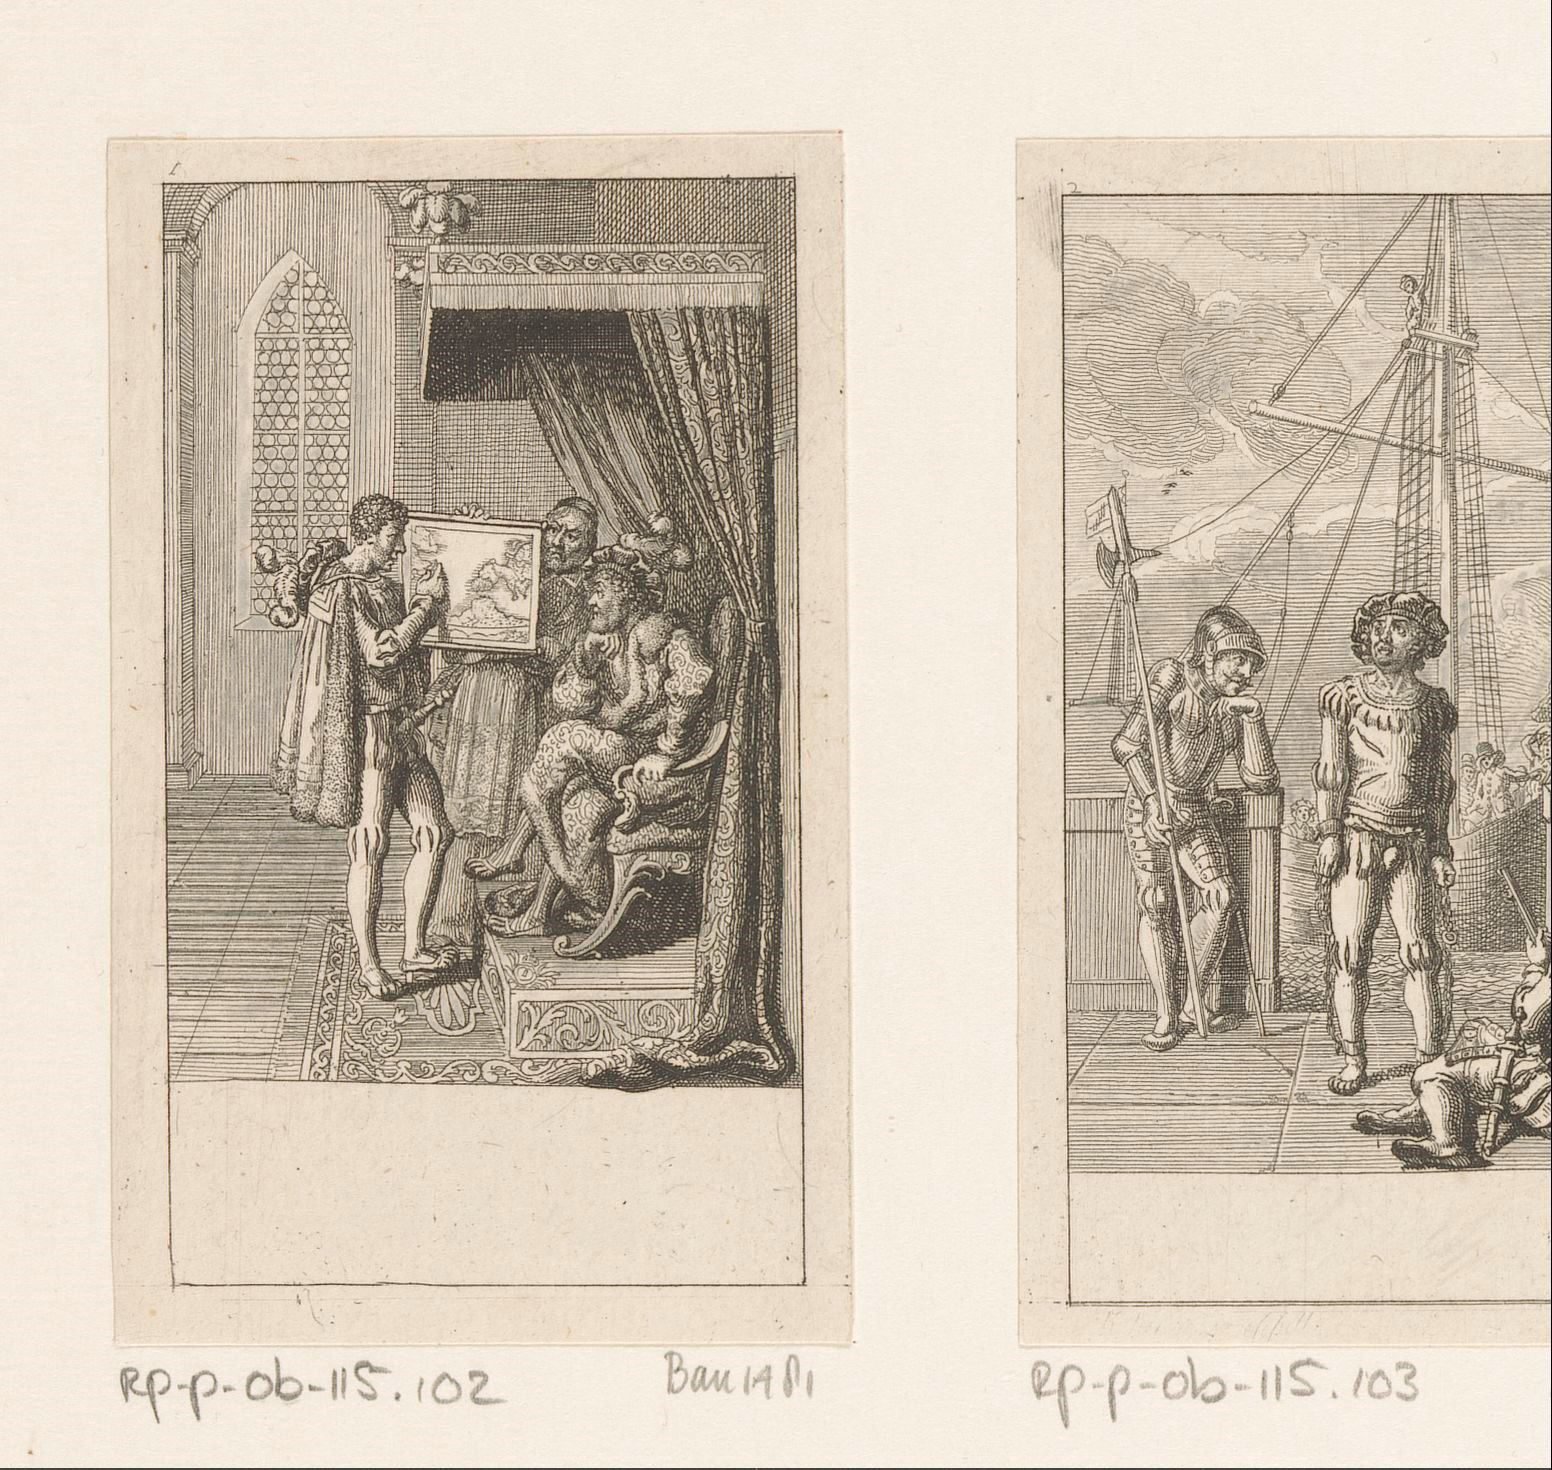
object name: print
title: Columbus legt zijn plan voor aan de Portugese koning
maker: daniel nikolaus chodowiecki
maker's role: draughtsman, print maker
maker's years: 1726-1801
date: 1790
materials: paper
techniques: etching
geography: berlin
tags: history, exploration, expedition, voyage of discovery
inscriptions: collector's mark: Lugt 2228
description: Latere staat gebruikt voor: Gothaischer Hof Kalender zum Nutzen und Vergnügen eingerichtet auf das Jahr 1791. Gotha: C. W. Ettinger, [1790].